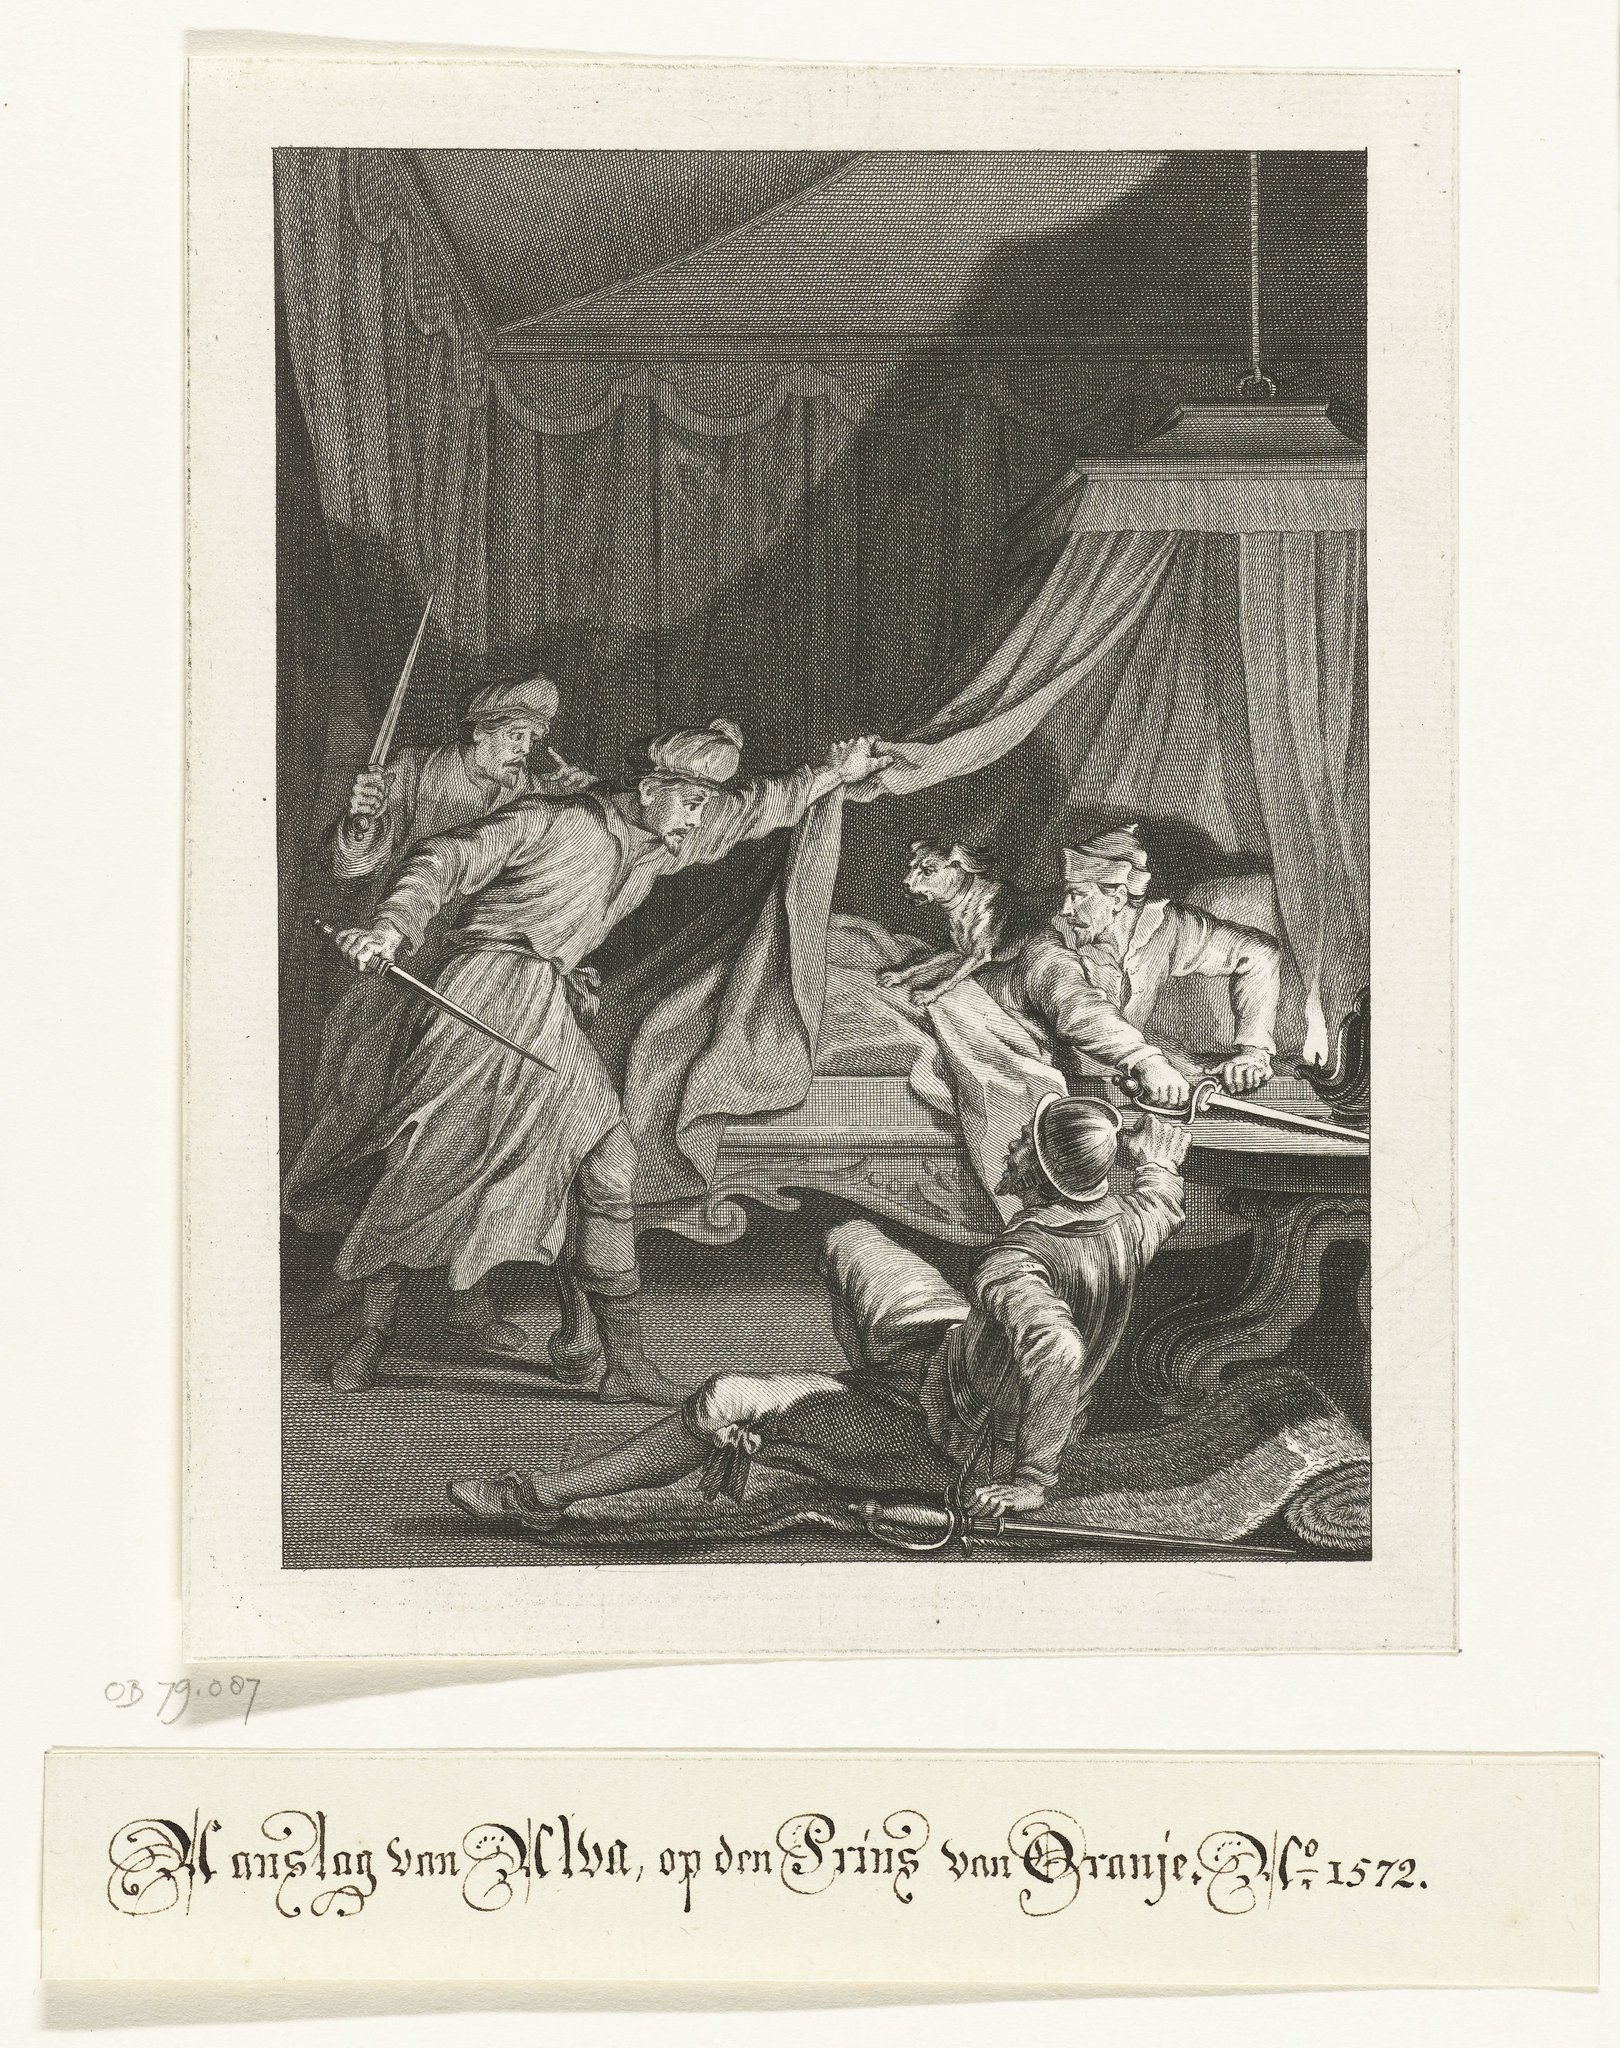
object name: print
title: Aanslag van Alva, op den Prins van Oranje, Ao. 1572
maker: theodoor koning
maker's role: print maker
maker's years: 1748-1829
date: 1780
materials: paper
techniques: etching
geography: northern netherlands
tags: delft, william i (prince of orange), attempt, political murder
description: Illustratie voor: J. Nomsz, Willem de eerste, of de grondlegging der Nederlandsche vryheid. : In vier en twintig zangen, Erven van David Klippink, Amsterdam 1779. Staat vóór de letter. Met de handgeschreven titel in pen in bruin op een apart papiertje.